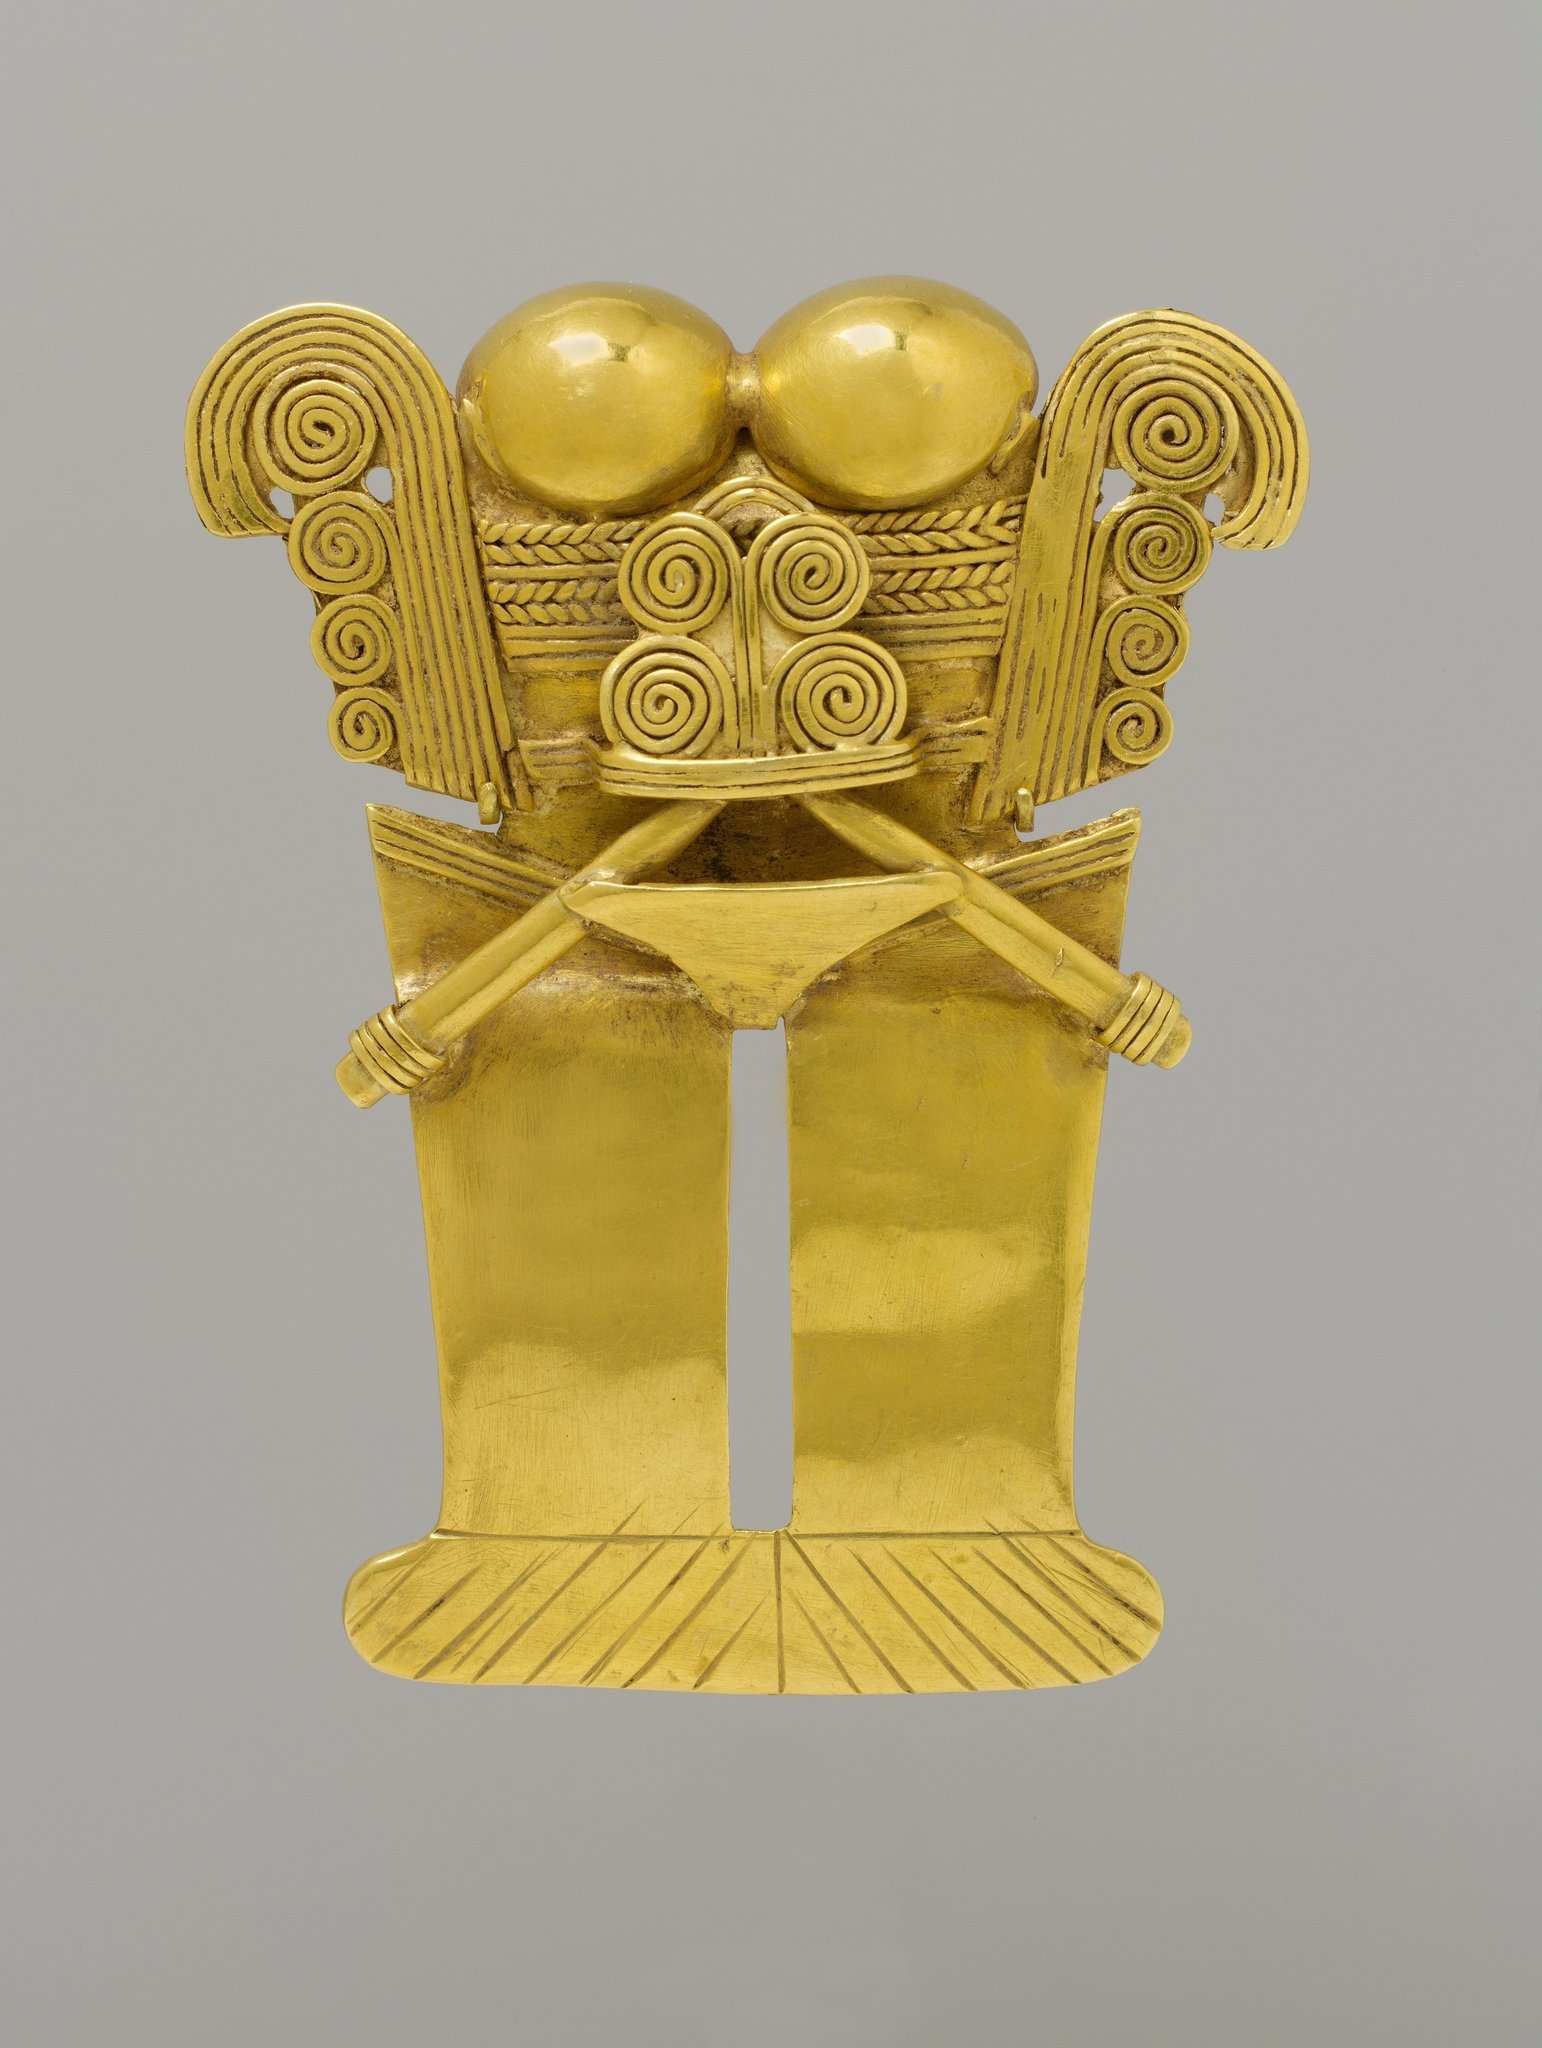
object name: pendant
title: Stylized Figure Pendant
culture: darien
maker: darién artist(s)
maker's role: artist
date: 1-900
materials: gold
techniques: hammering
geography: colombia